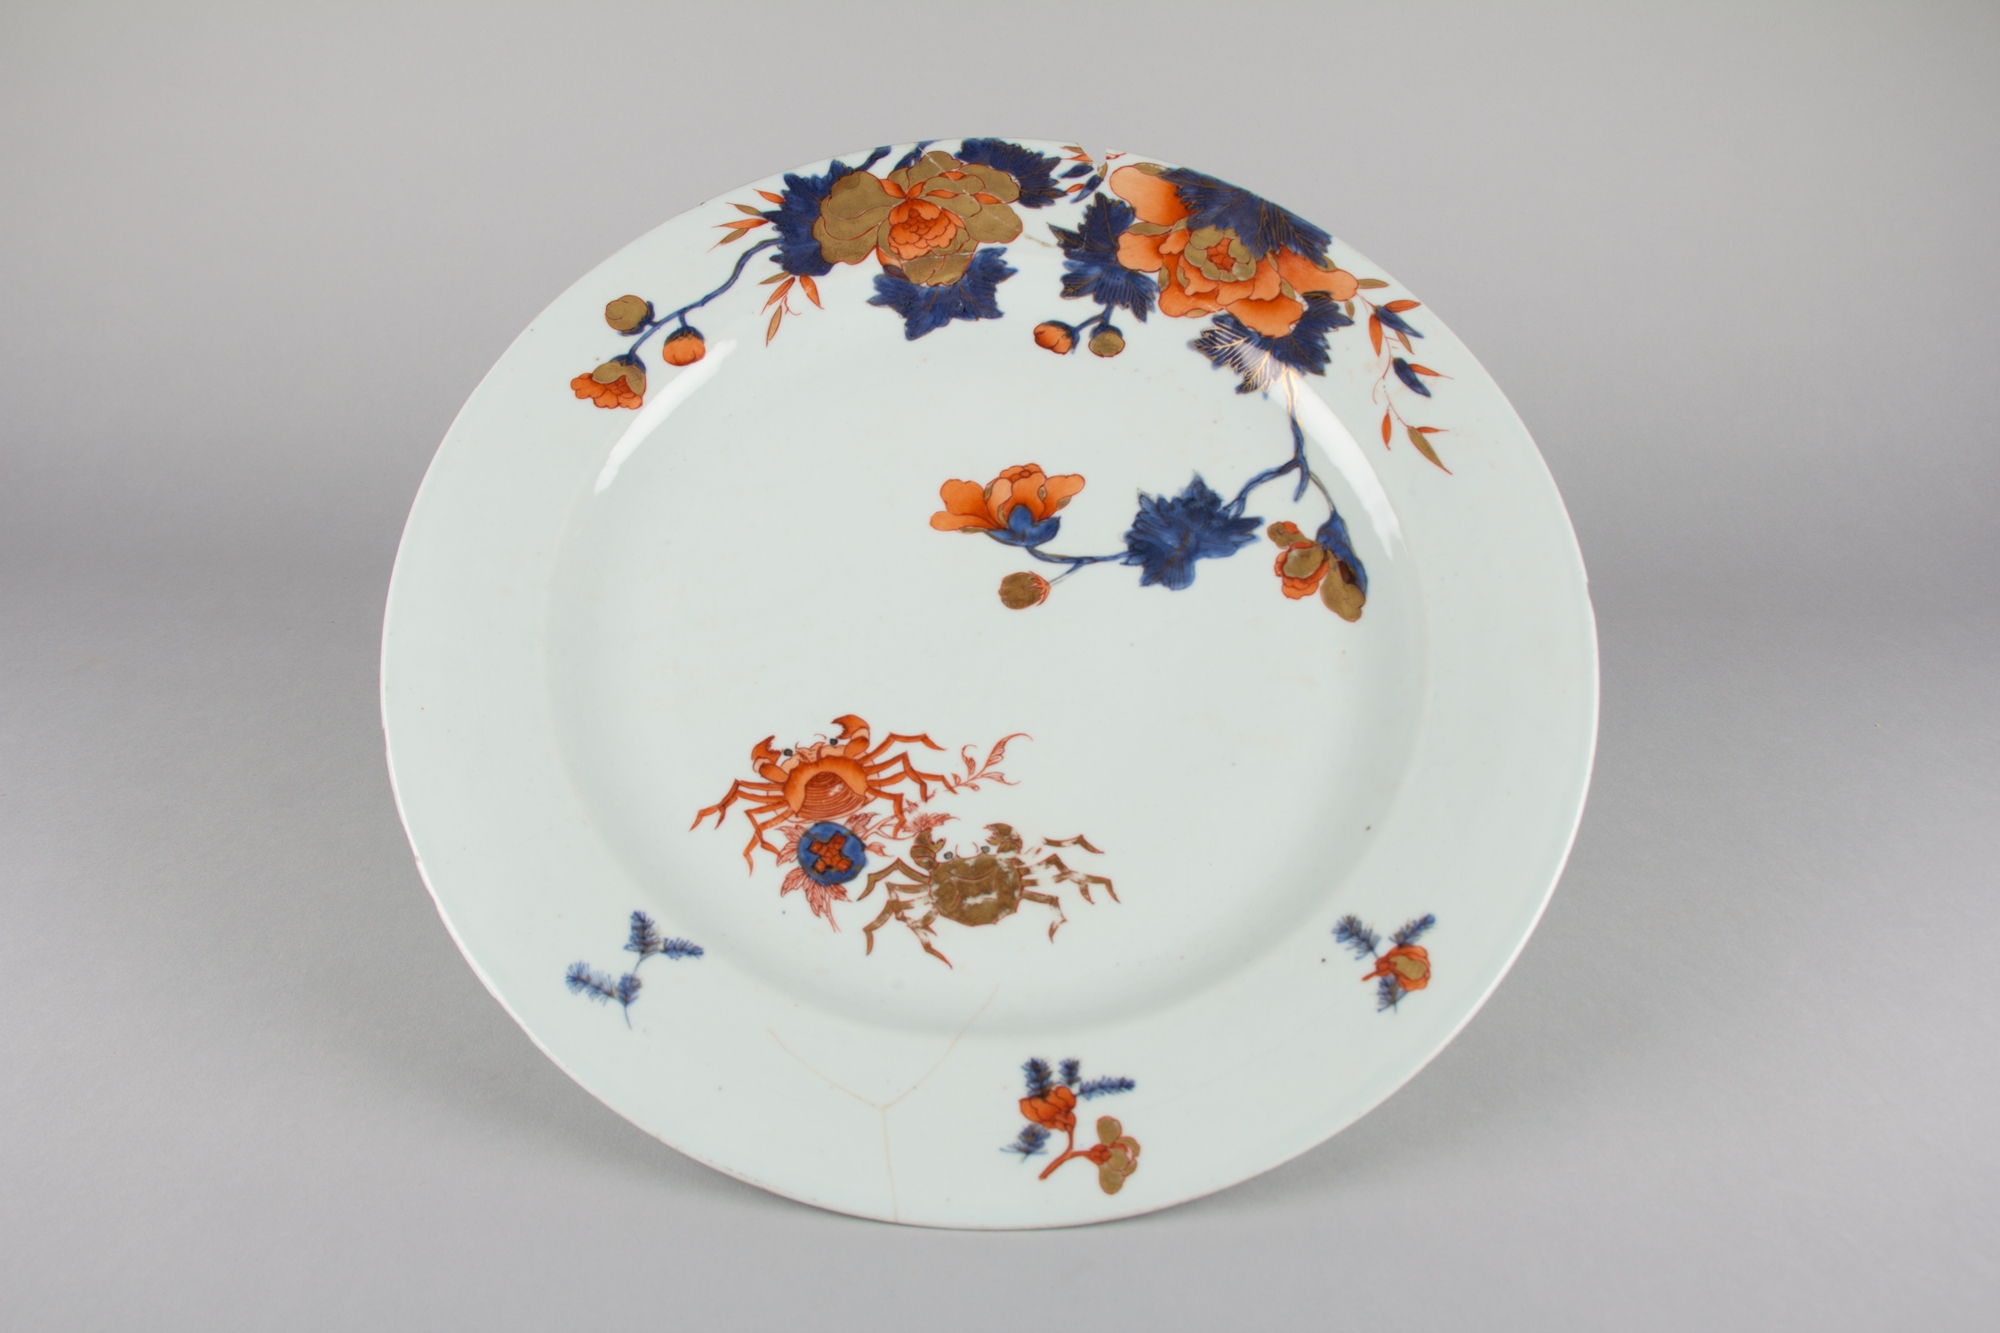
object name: dish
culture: chinese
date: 1767-1900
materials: gilt, iron, porcelain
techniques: overglaze, painting, underglaze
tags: crabs,flowers